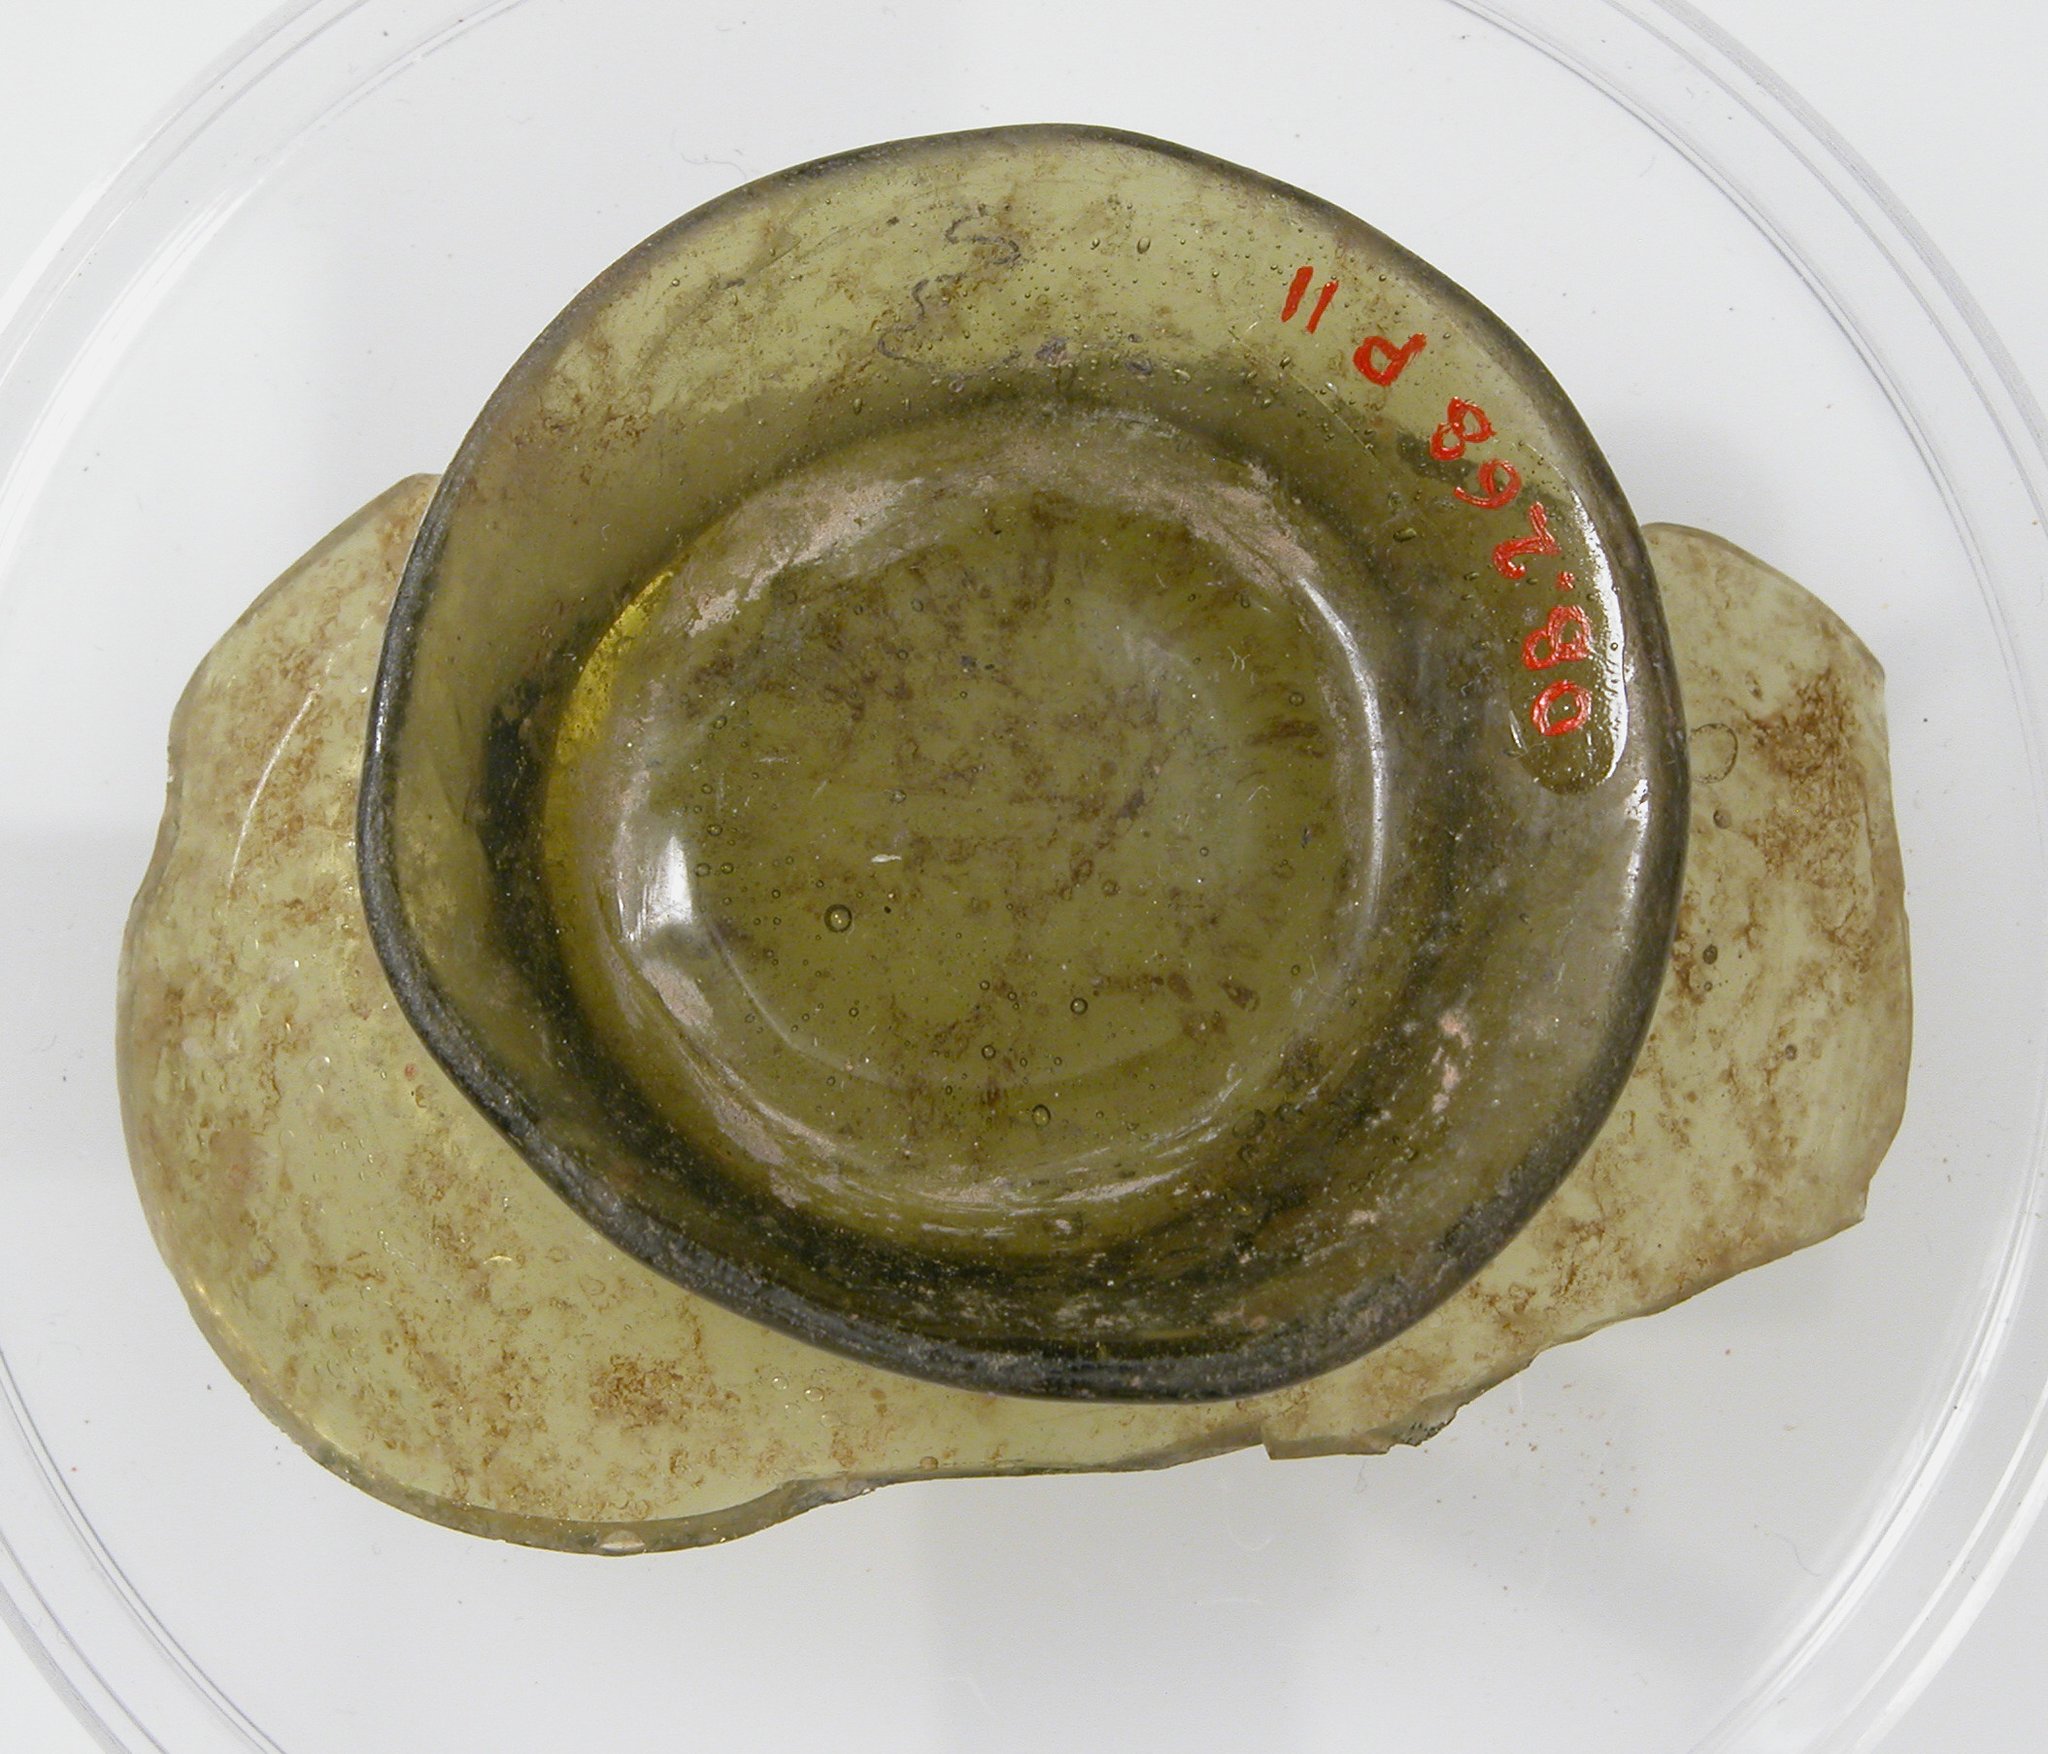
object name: fragment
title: Foot of a Vessel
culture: coptic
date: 301-433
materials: glass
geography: egypt